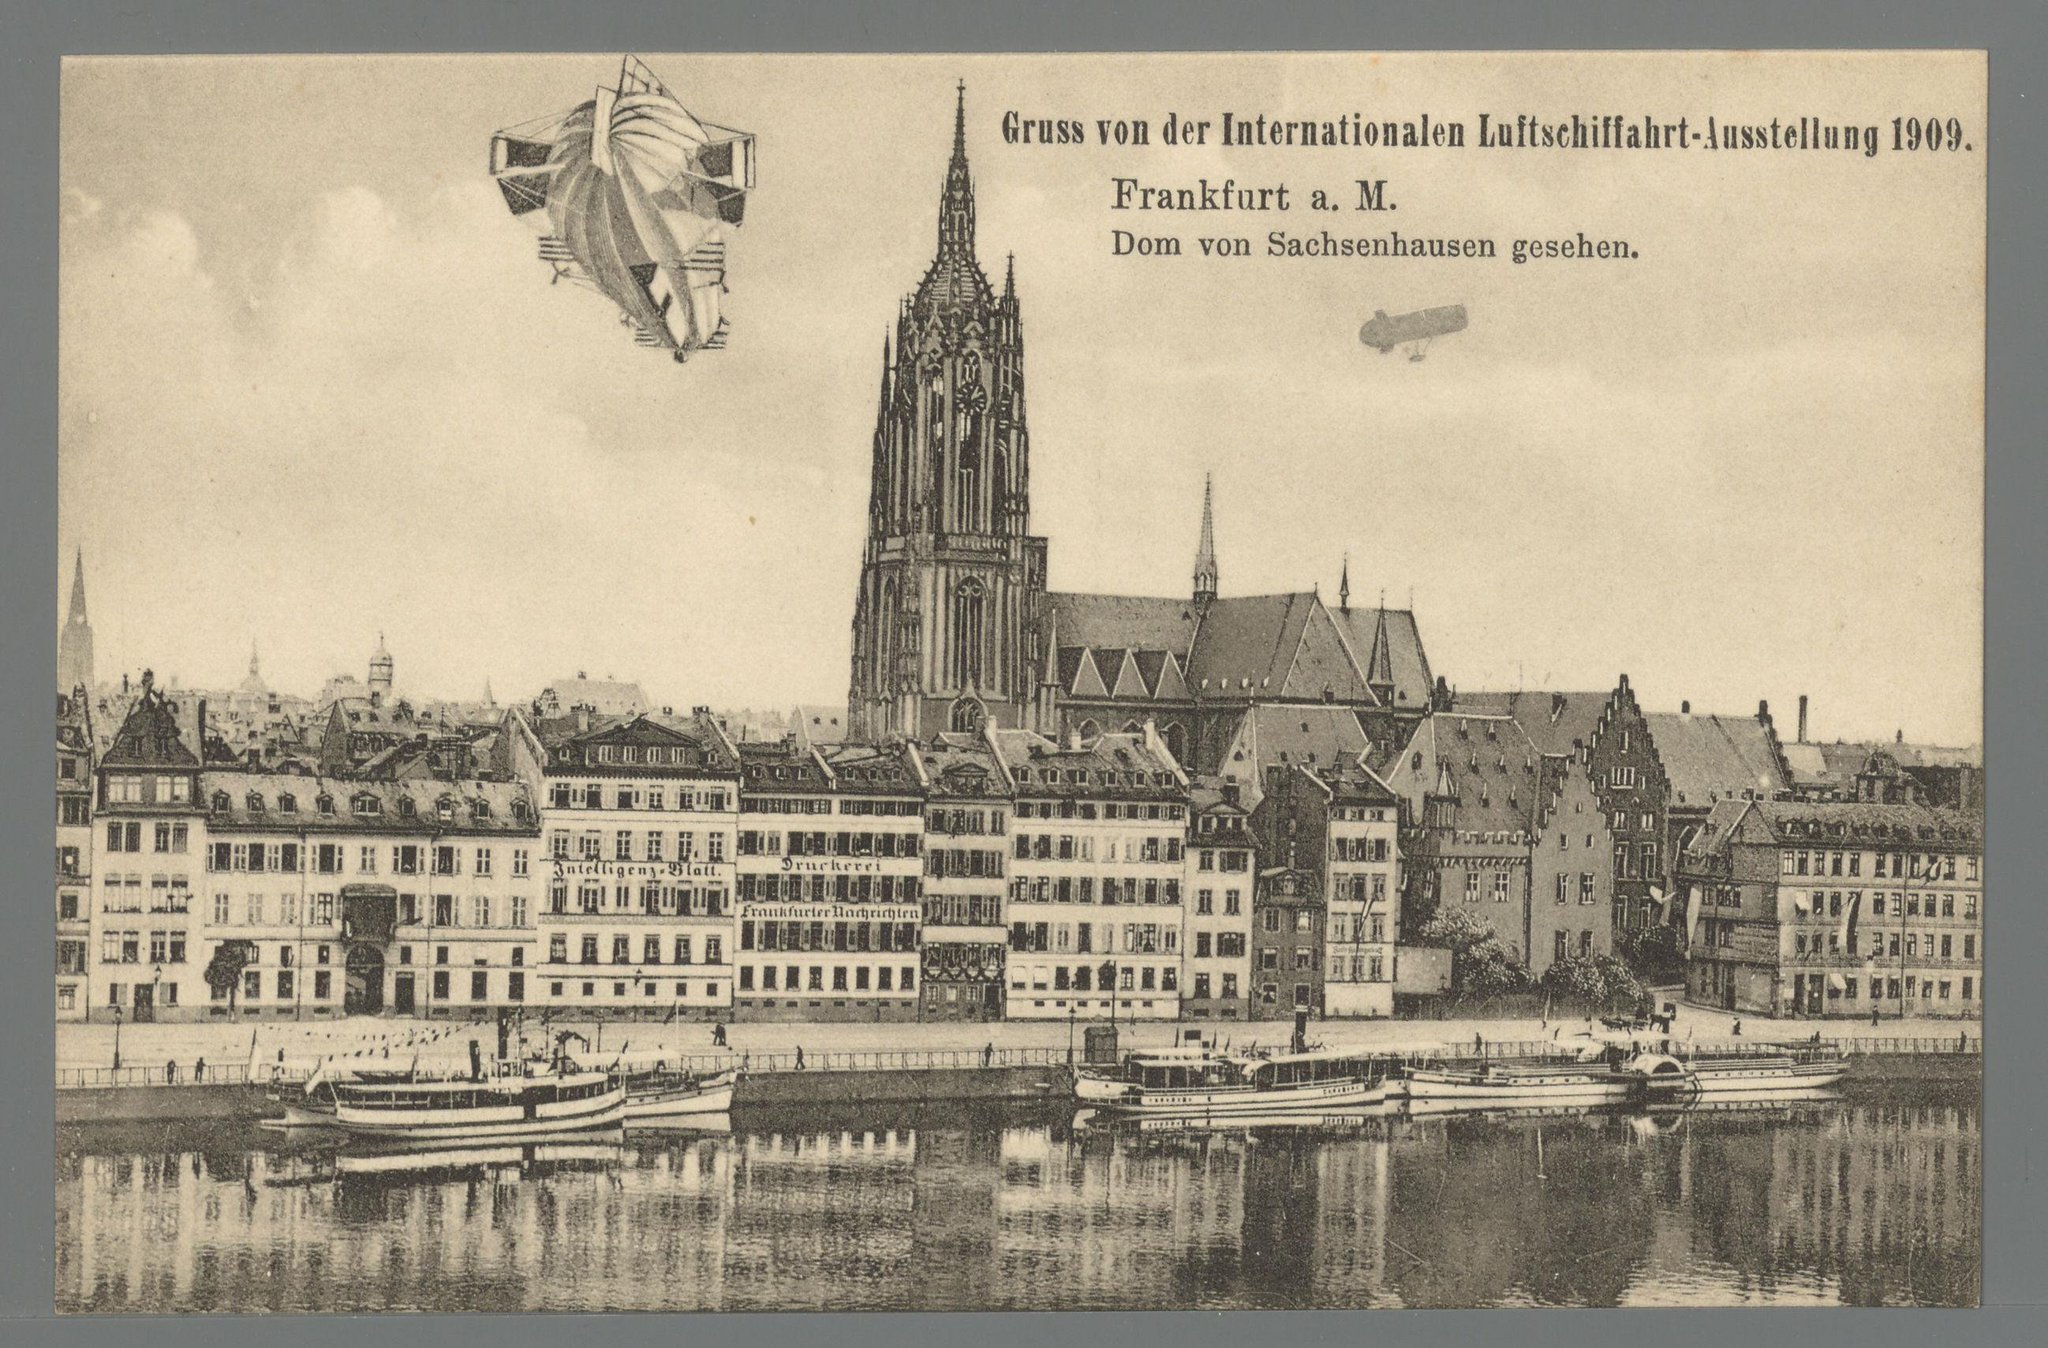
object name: ansichtkaart, prentbriefkaart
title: Gruss von der Internationalen Luftschiffahrt-Ausstellung 1909. Frankfurt a. M. Dom von Sachsenhausen gesehen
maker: Anonymous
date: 1909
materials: cardboard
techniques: photograph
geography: trier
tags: city-view, and landscape with man-made constructions, 46c35 airship, zeppelin, church (exterior), temporary exhibition, 'salon'